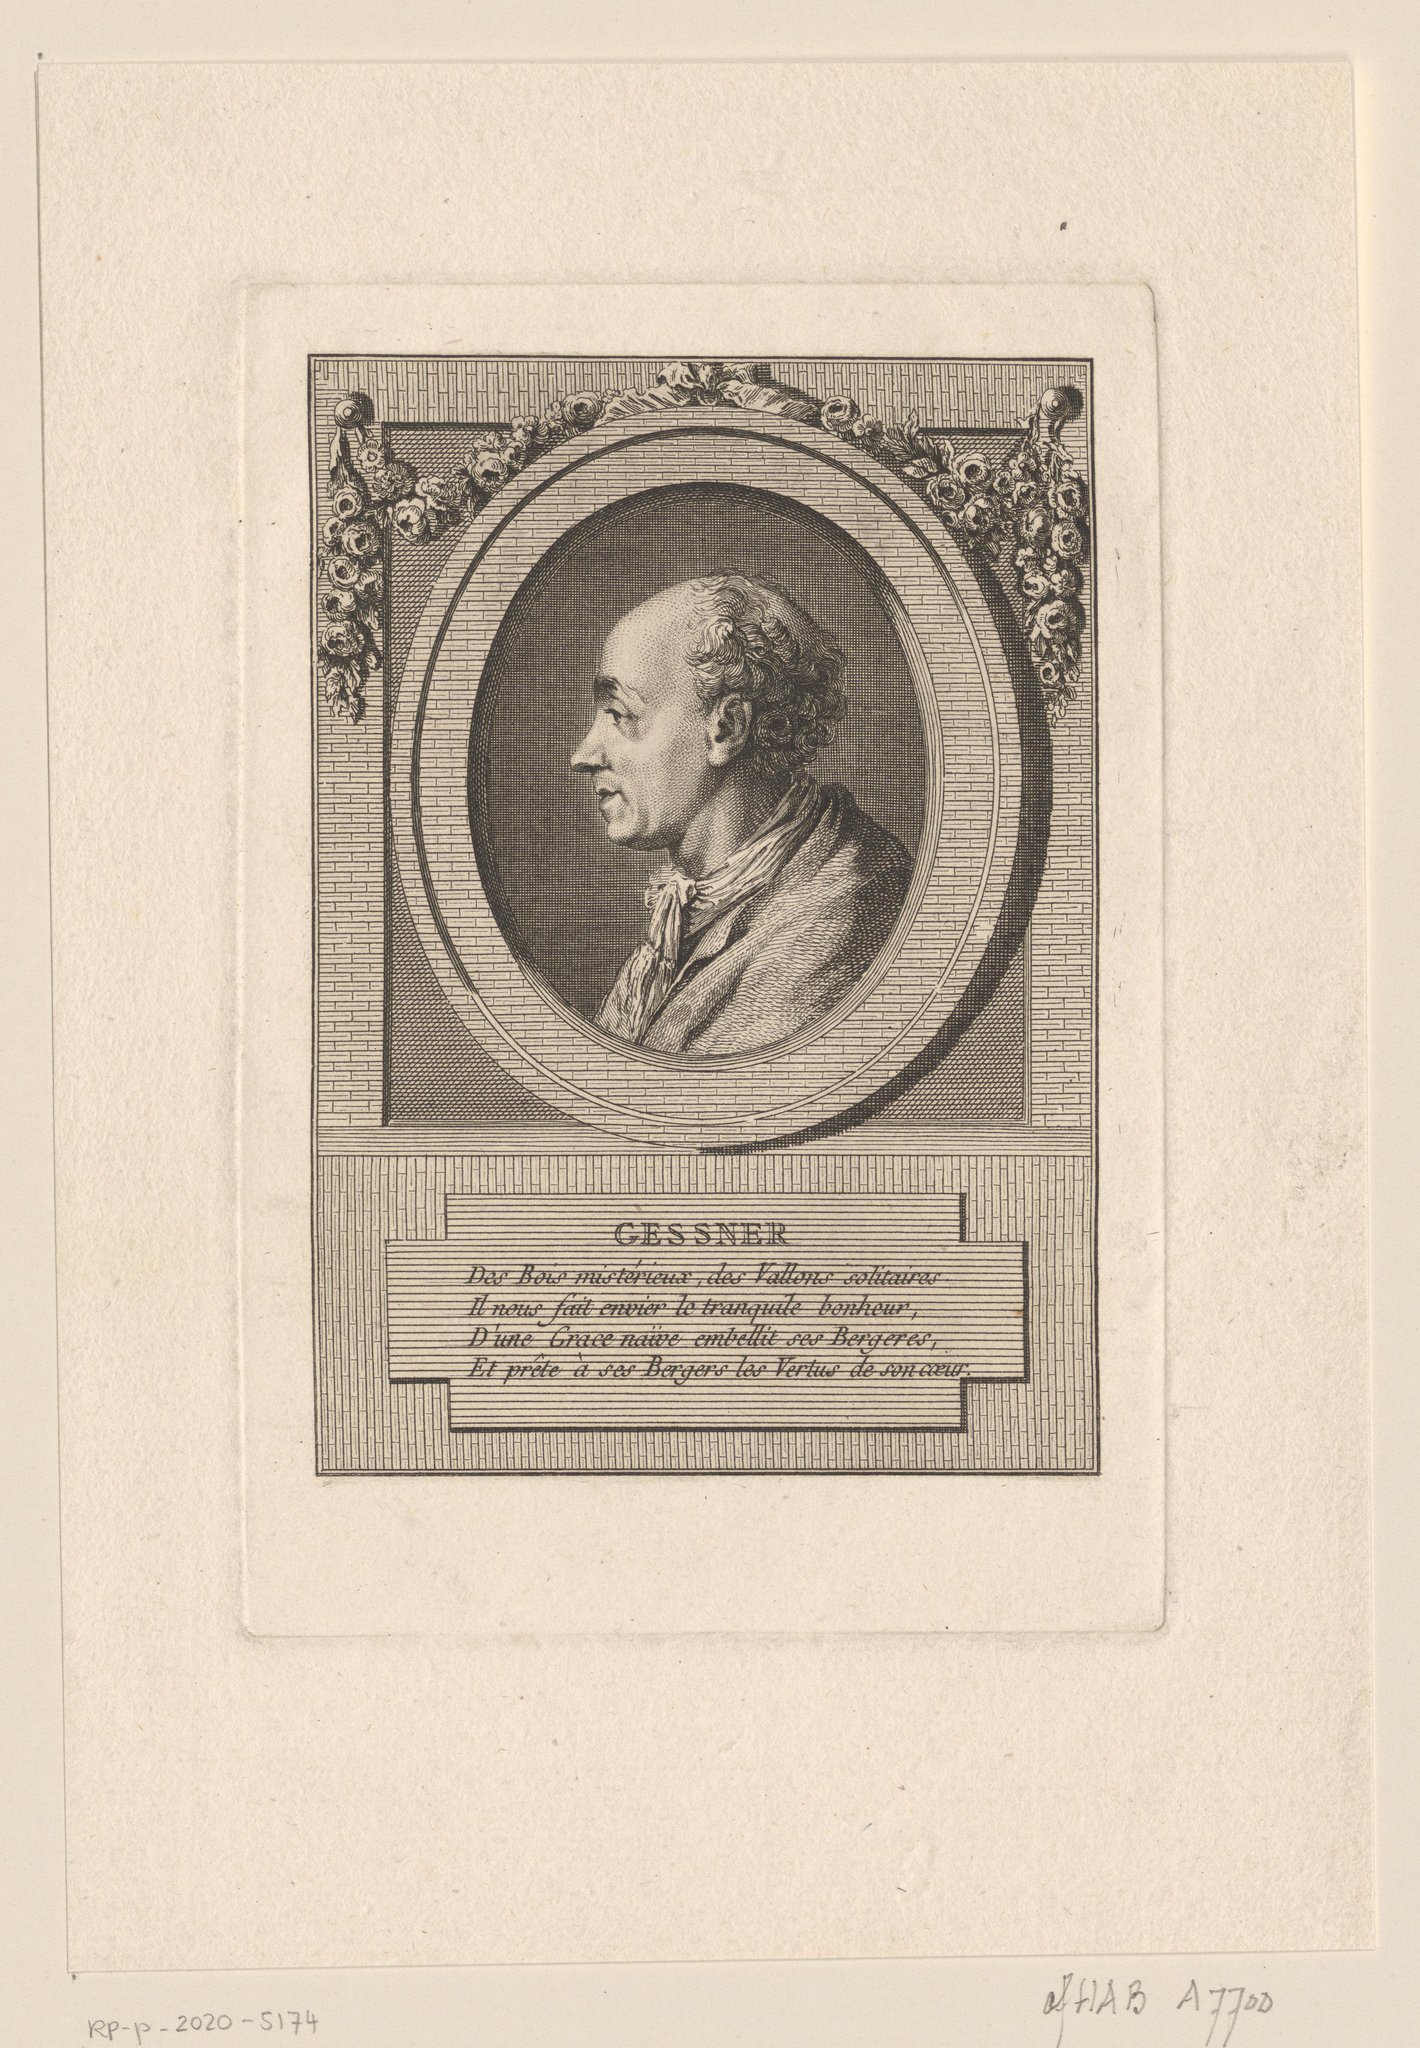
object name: print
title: Portret van Salomon Gessner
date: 1757-1815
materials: paper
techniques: engraving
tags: painter, print maker, salomon gessner, historical persons, portrait, self-portrait of painter, writer, poet, author